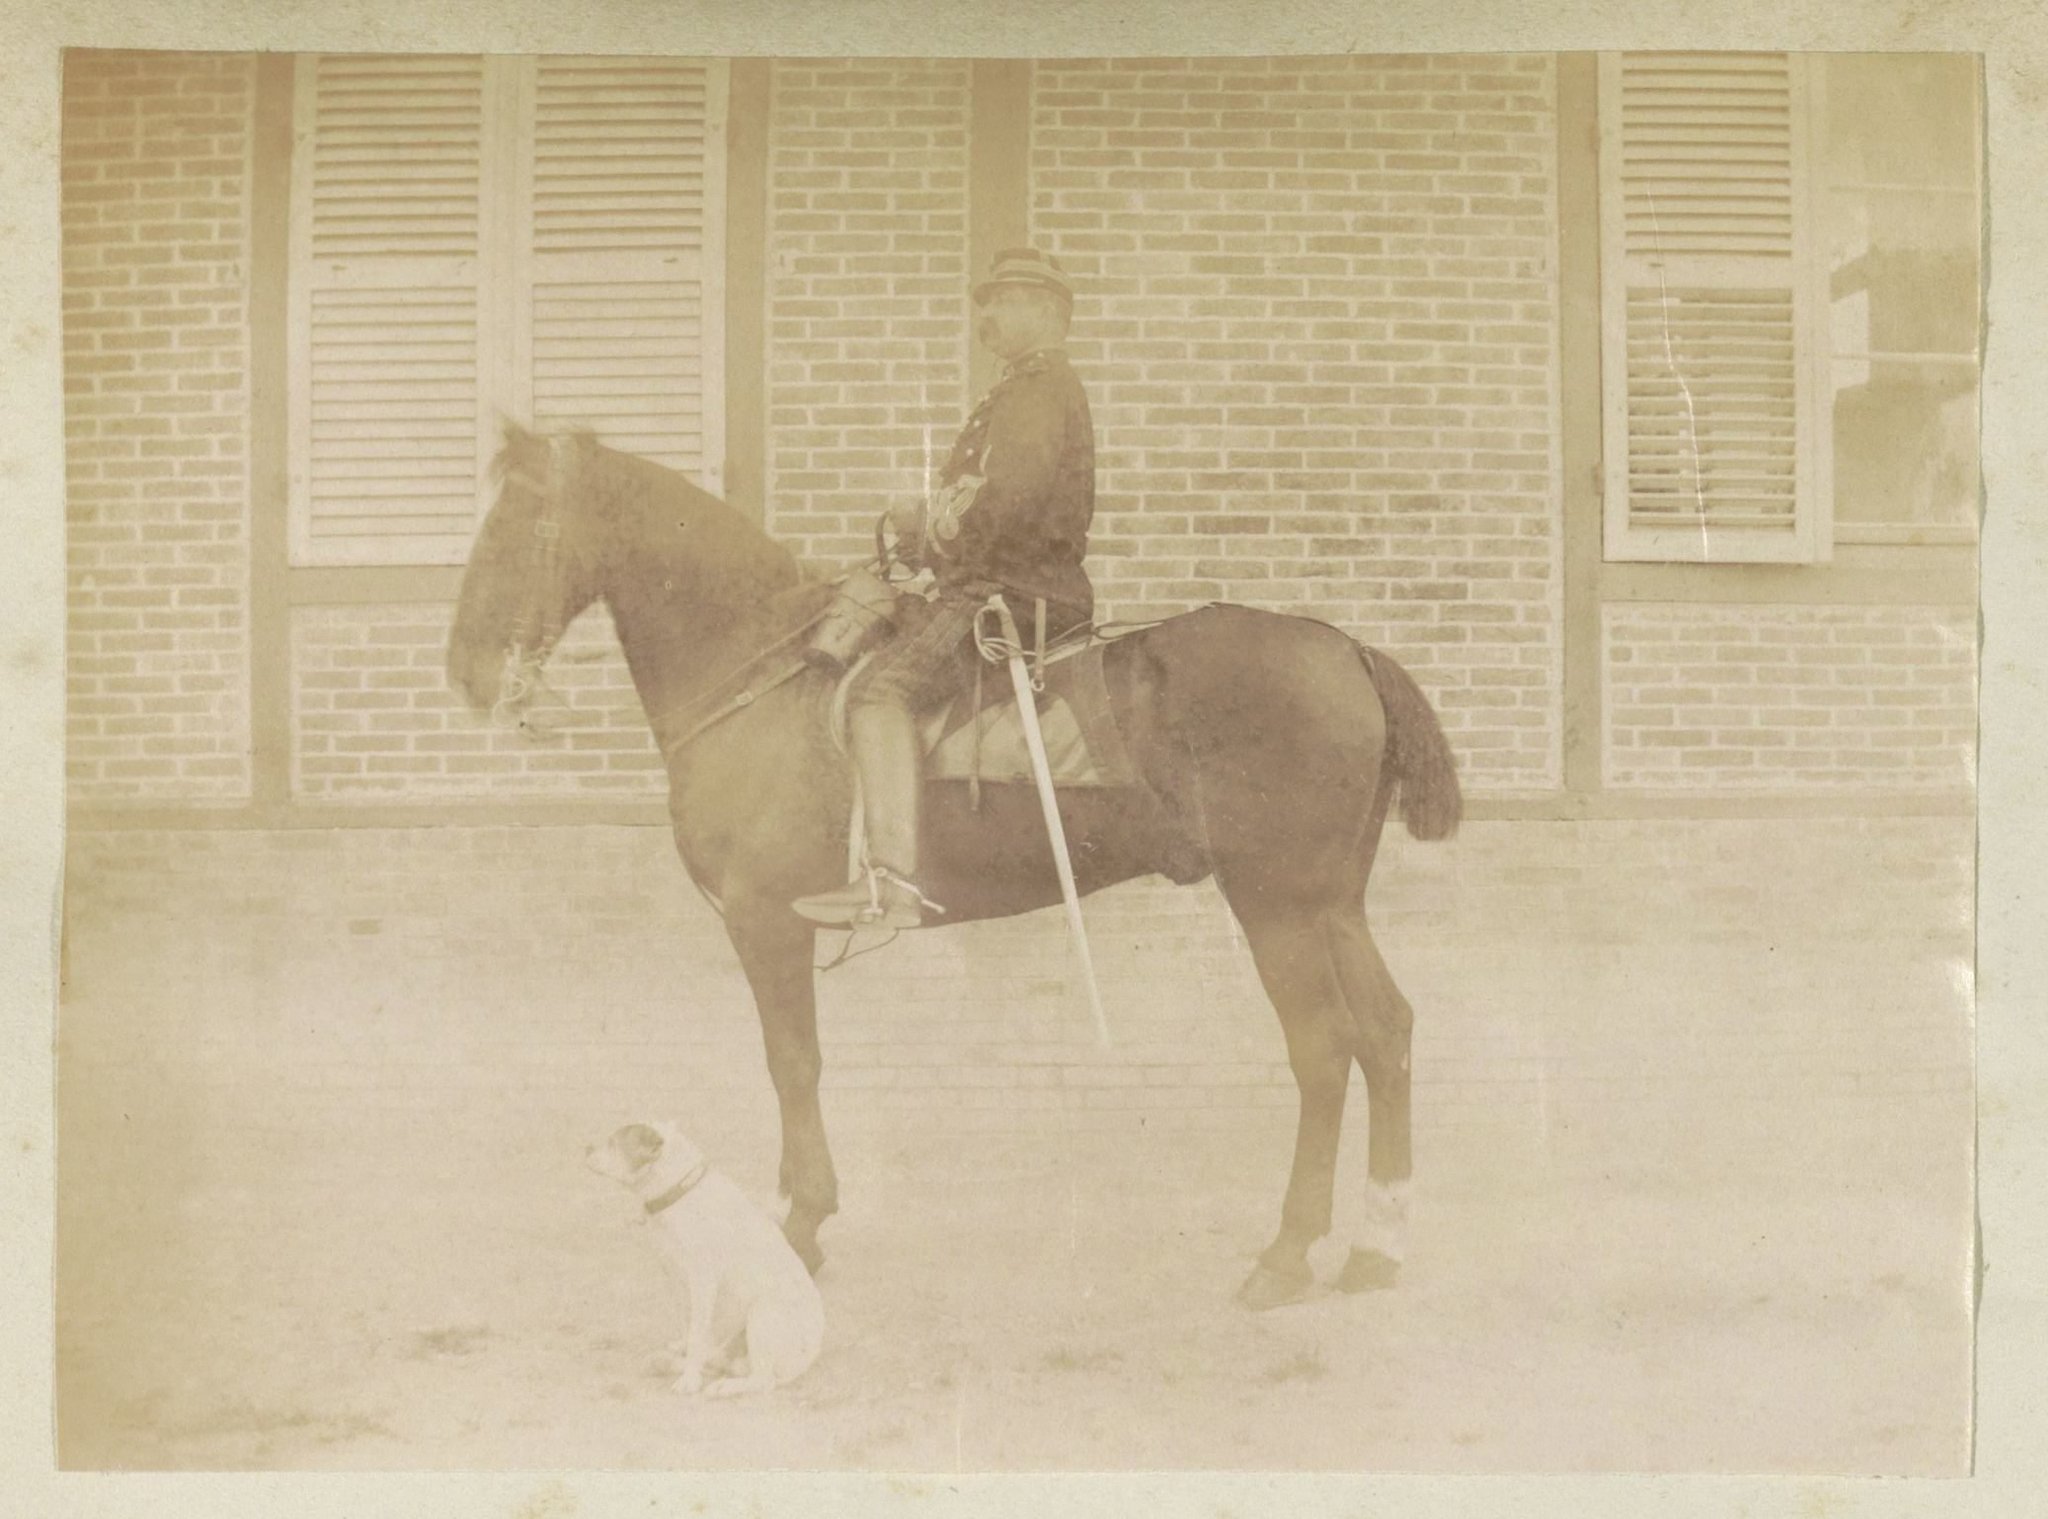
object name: photograph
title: Portret van een Franse militair te paard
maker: Anonymous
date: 1805-1884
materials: photographic support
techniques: albumen print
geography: france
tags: land forces (+ cavalry, horsemen)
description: Onderdeel van Album van een Franse amateurfotograaf met opnames van familie, militairen, industrie, landschappen en bezienswaardigheden in Frankrijk.